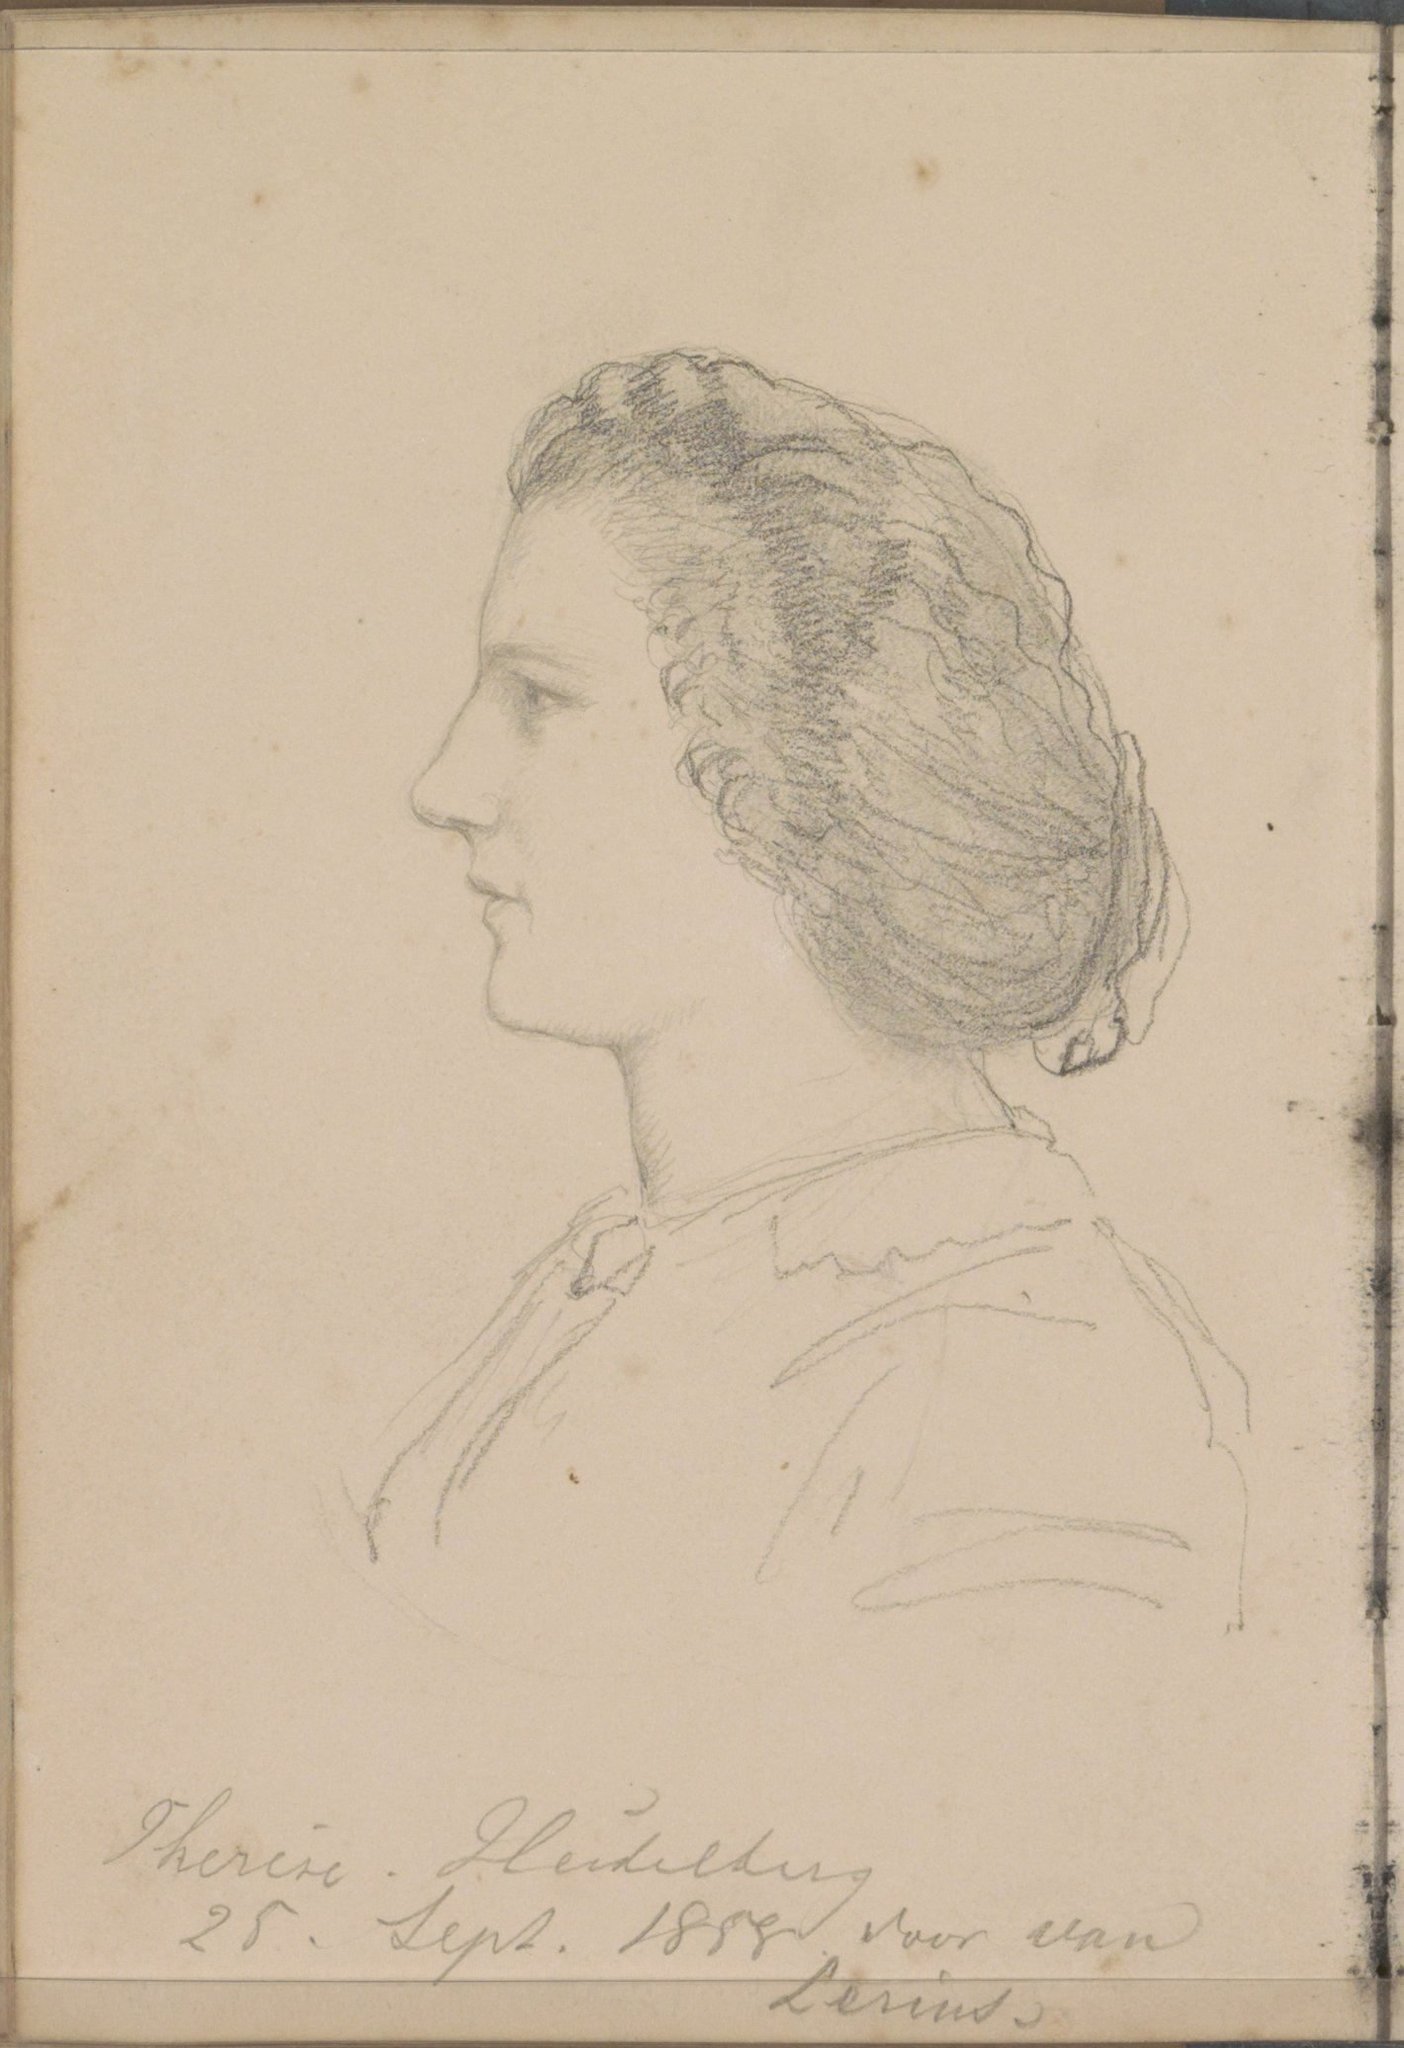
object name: sketchbook leaf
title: Portret van Thérèse, van opzij gezien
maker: johannes tavenraat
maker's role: draughtsman, painter, print maker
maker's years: 1809-1881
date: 1809-1858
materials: paper, pencil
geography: heidelberg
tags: head (human), adult woman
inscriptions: date and inscription: ‘Therèse . Heidelberg/ 25. Sept. 1858 voor van/ Le[...]ins’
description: Blad 44 verso uit een schetsboek met 47 bladen.